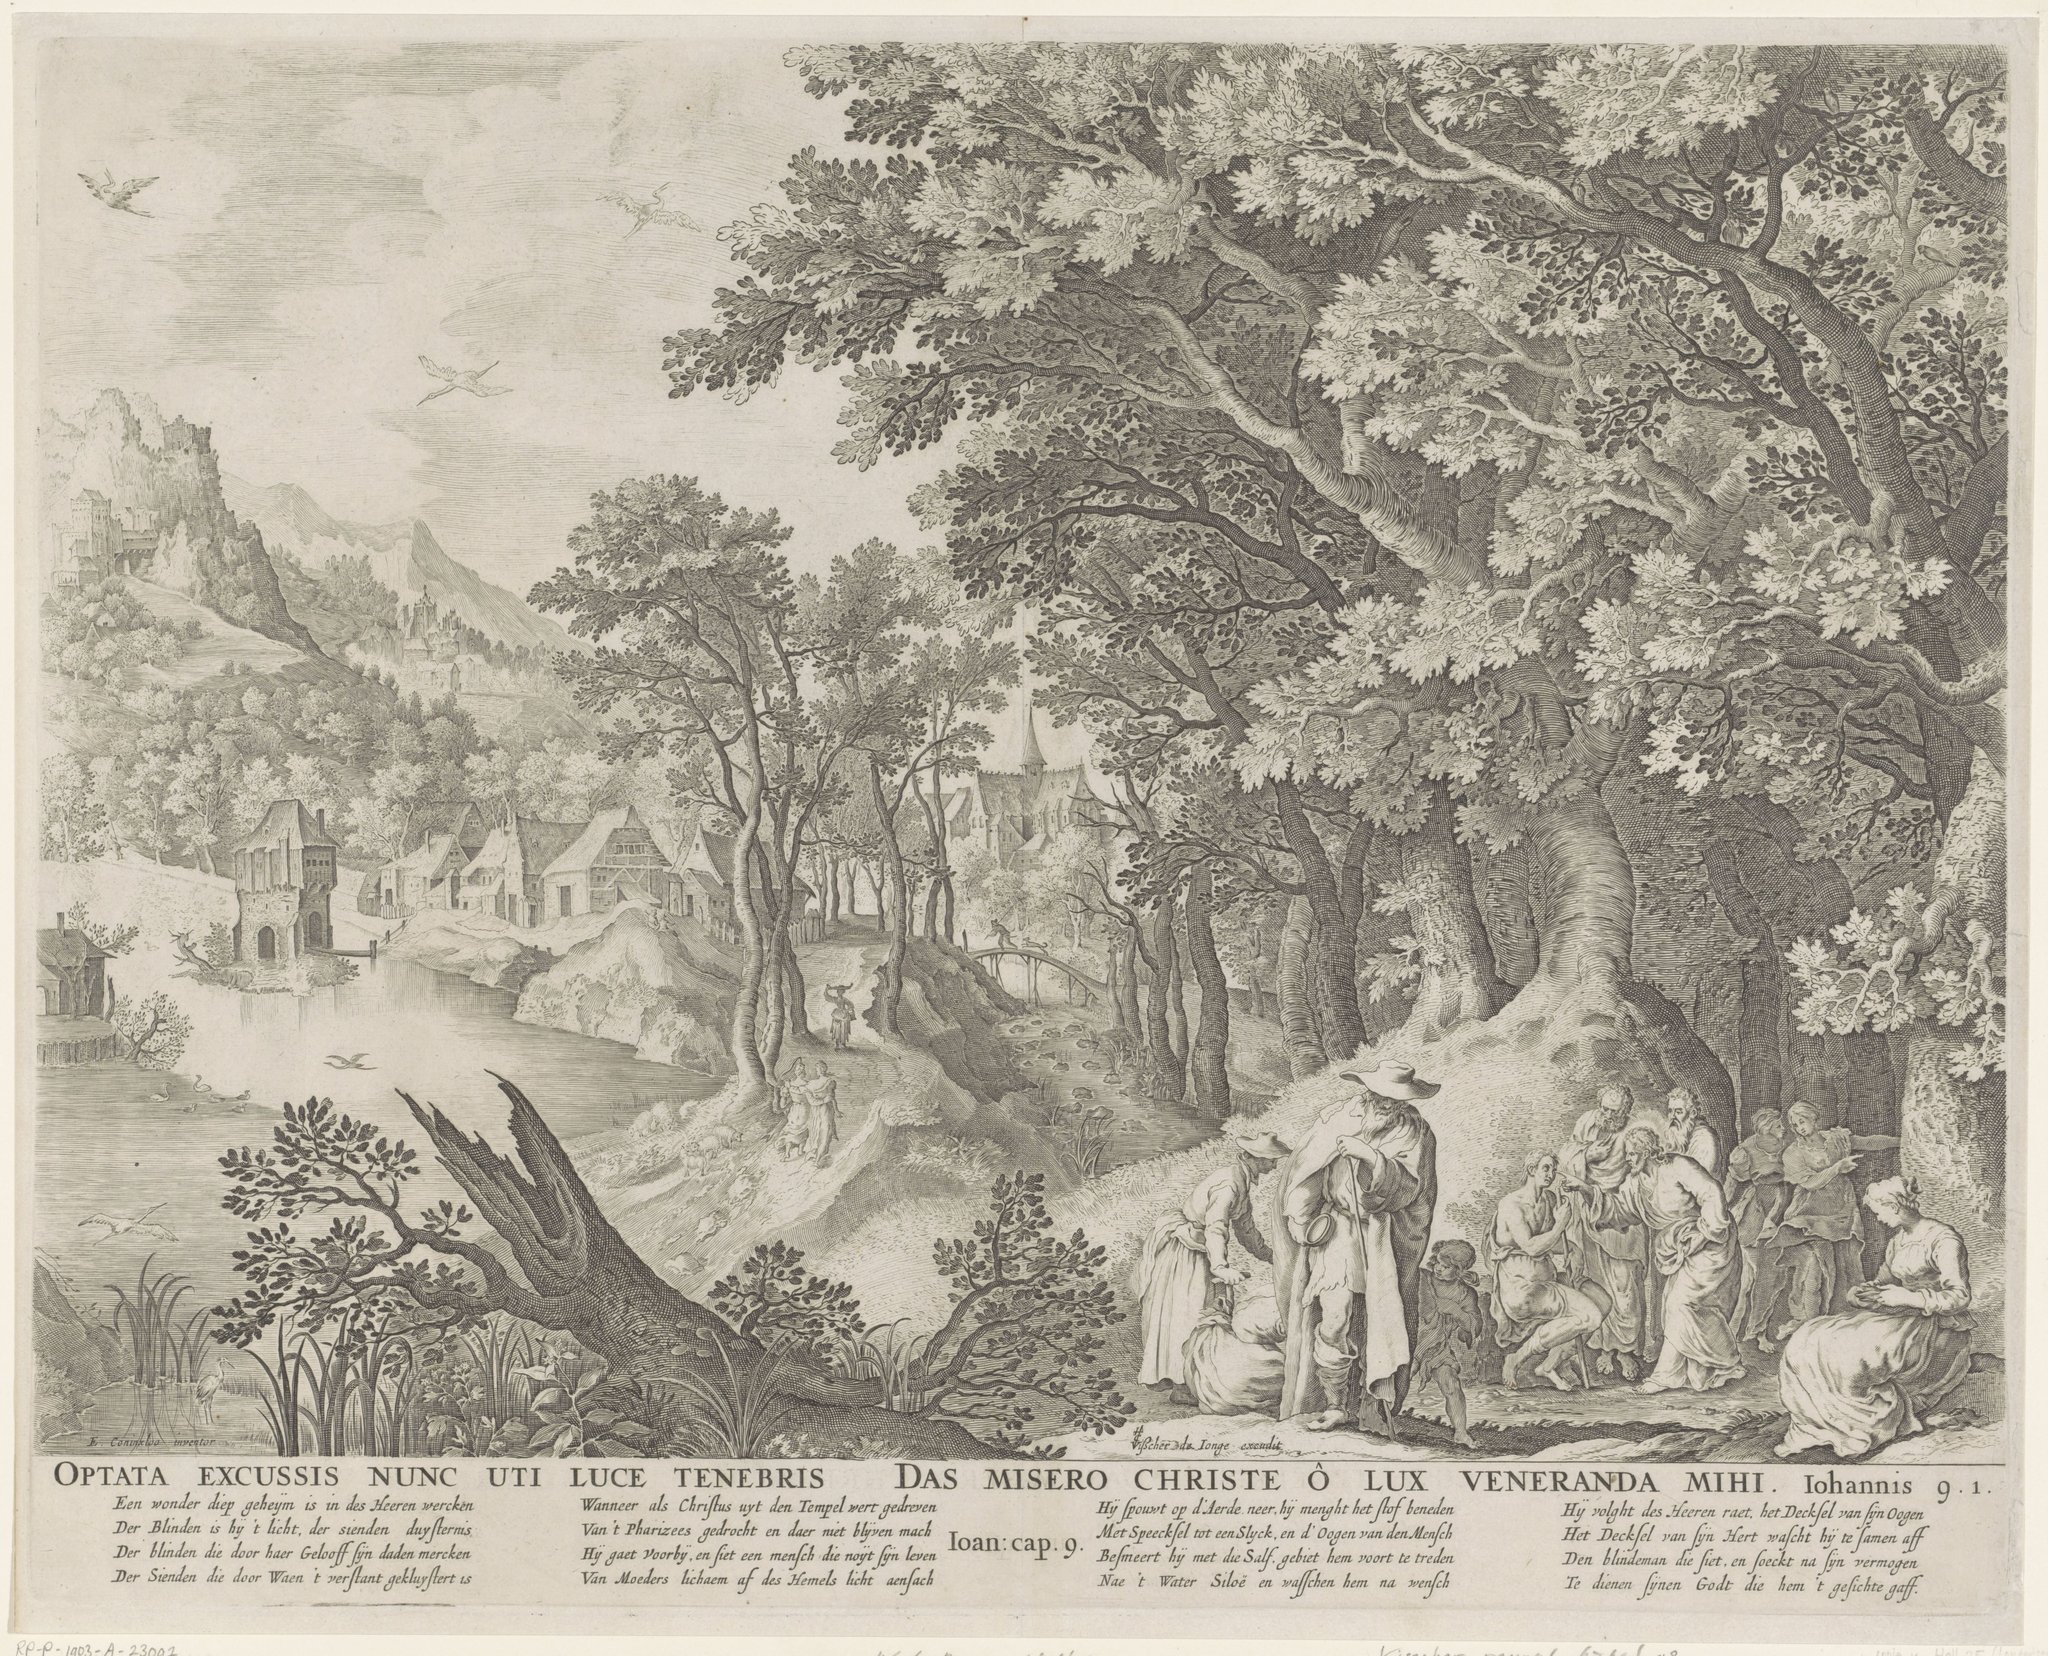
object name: print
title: Royaalbijbel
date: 1652-1702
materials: paper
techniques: engraving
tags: healing of a man born blind: christ touches his eyes with an 'ointment' of dust and spittle (john 9)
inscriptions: collector's mark: Lugt 2228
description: De Amsterdamse uitgever Claes Jansz. Visscher (II) produceerde vanaf de jaren ’30 van de zeventiende eeuw grote Bijbelse prenten op zogenaamd royaal-formaat papier (ca. 480 x 580 mm). Na zijn dood in 1652 zette zijn zoon Nicolaes Visscher (I) het bedrijf voort en zo ook de uitgave van Royaalbijbelprenten. Toen Nicolaes in 1679 overleed nam zijn zoon Nicolaes Visscher (II) het bedrijf over en gaf kort hierna, omstreeks 1680, een fondslijst uit. Hierin worden 130 prenten met Bijbelse voorstellingen op royaalpapier beschreven (zie documentatie J. van der Waals). Complete prentbijbels op royaal-formaat werden door vader en zoon Nicolaes Visscher uitgegeven onder de titel Historiae Sacrae Veteris et Novi Testamenti. De bladen werden echter ook los verkocht en konden worden gecombineerd met Royaalbijbel-prenten van andere uitgevers. Verschillende Amsterdamse uitgevers brachten namelijk ook bijbelprenten op royaal-formaat uit, onder wie Clement de Jonghe en Cornelis Danckerts. De door de firma Visscher uitgegeven prenten zijn veelal vervaardigd door anonieme prentmakers naar voorbeeld van verschillende zestiende- en zeventiende-eeuwse Bijbelse prenten en prentreeksen. Veelal moesten de composities worden aangepast aan het grotere en langgerekte royaal-formaat. Daarnaast zijn er ook grote bladen van bekende prentmakers zoals Jan van Londerseel, Pieter Nolpe, Jacques de Gheyn (II) en Jan Harmensz. Muller opgenomen in de categorie ‘Bybelsche Figuren, op Royaal-bladen’ in de fondslijst van Visscher. Prent mogelijk gebruikt in: Historiae Sacrae Veteris et Novi Testamenti (Royaalbijbel). Amsterdam: Nicolaes Visscher (I) en (II), [1652-1702]. In de fondslijst van Nicolaes Visscher II (ca. 1680) is het onderwerp van deze prent onder de titel 'Bybelsche Figuren, op Royaal-bladen. bestaande uyt de volgende historien.' als volgt genummerd: 98.